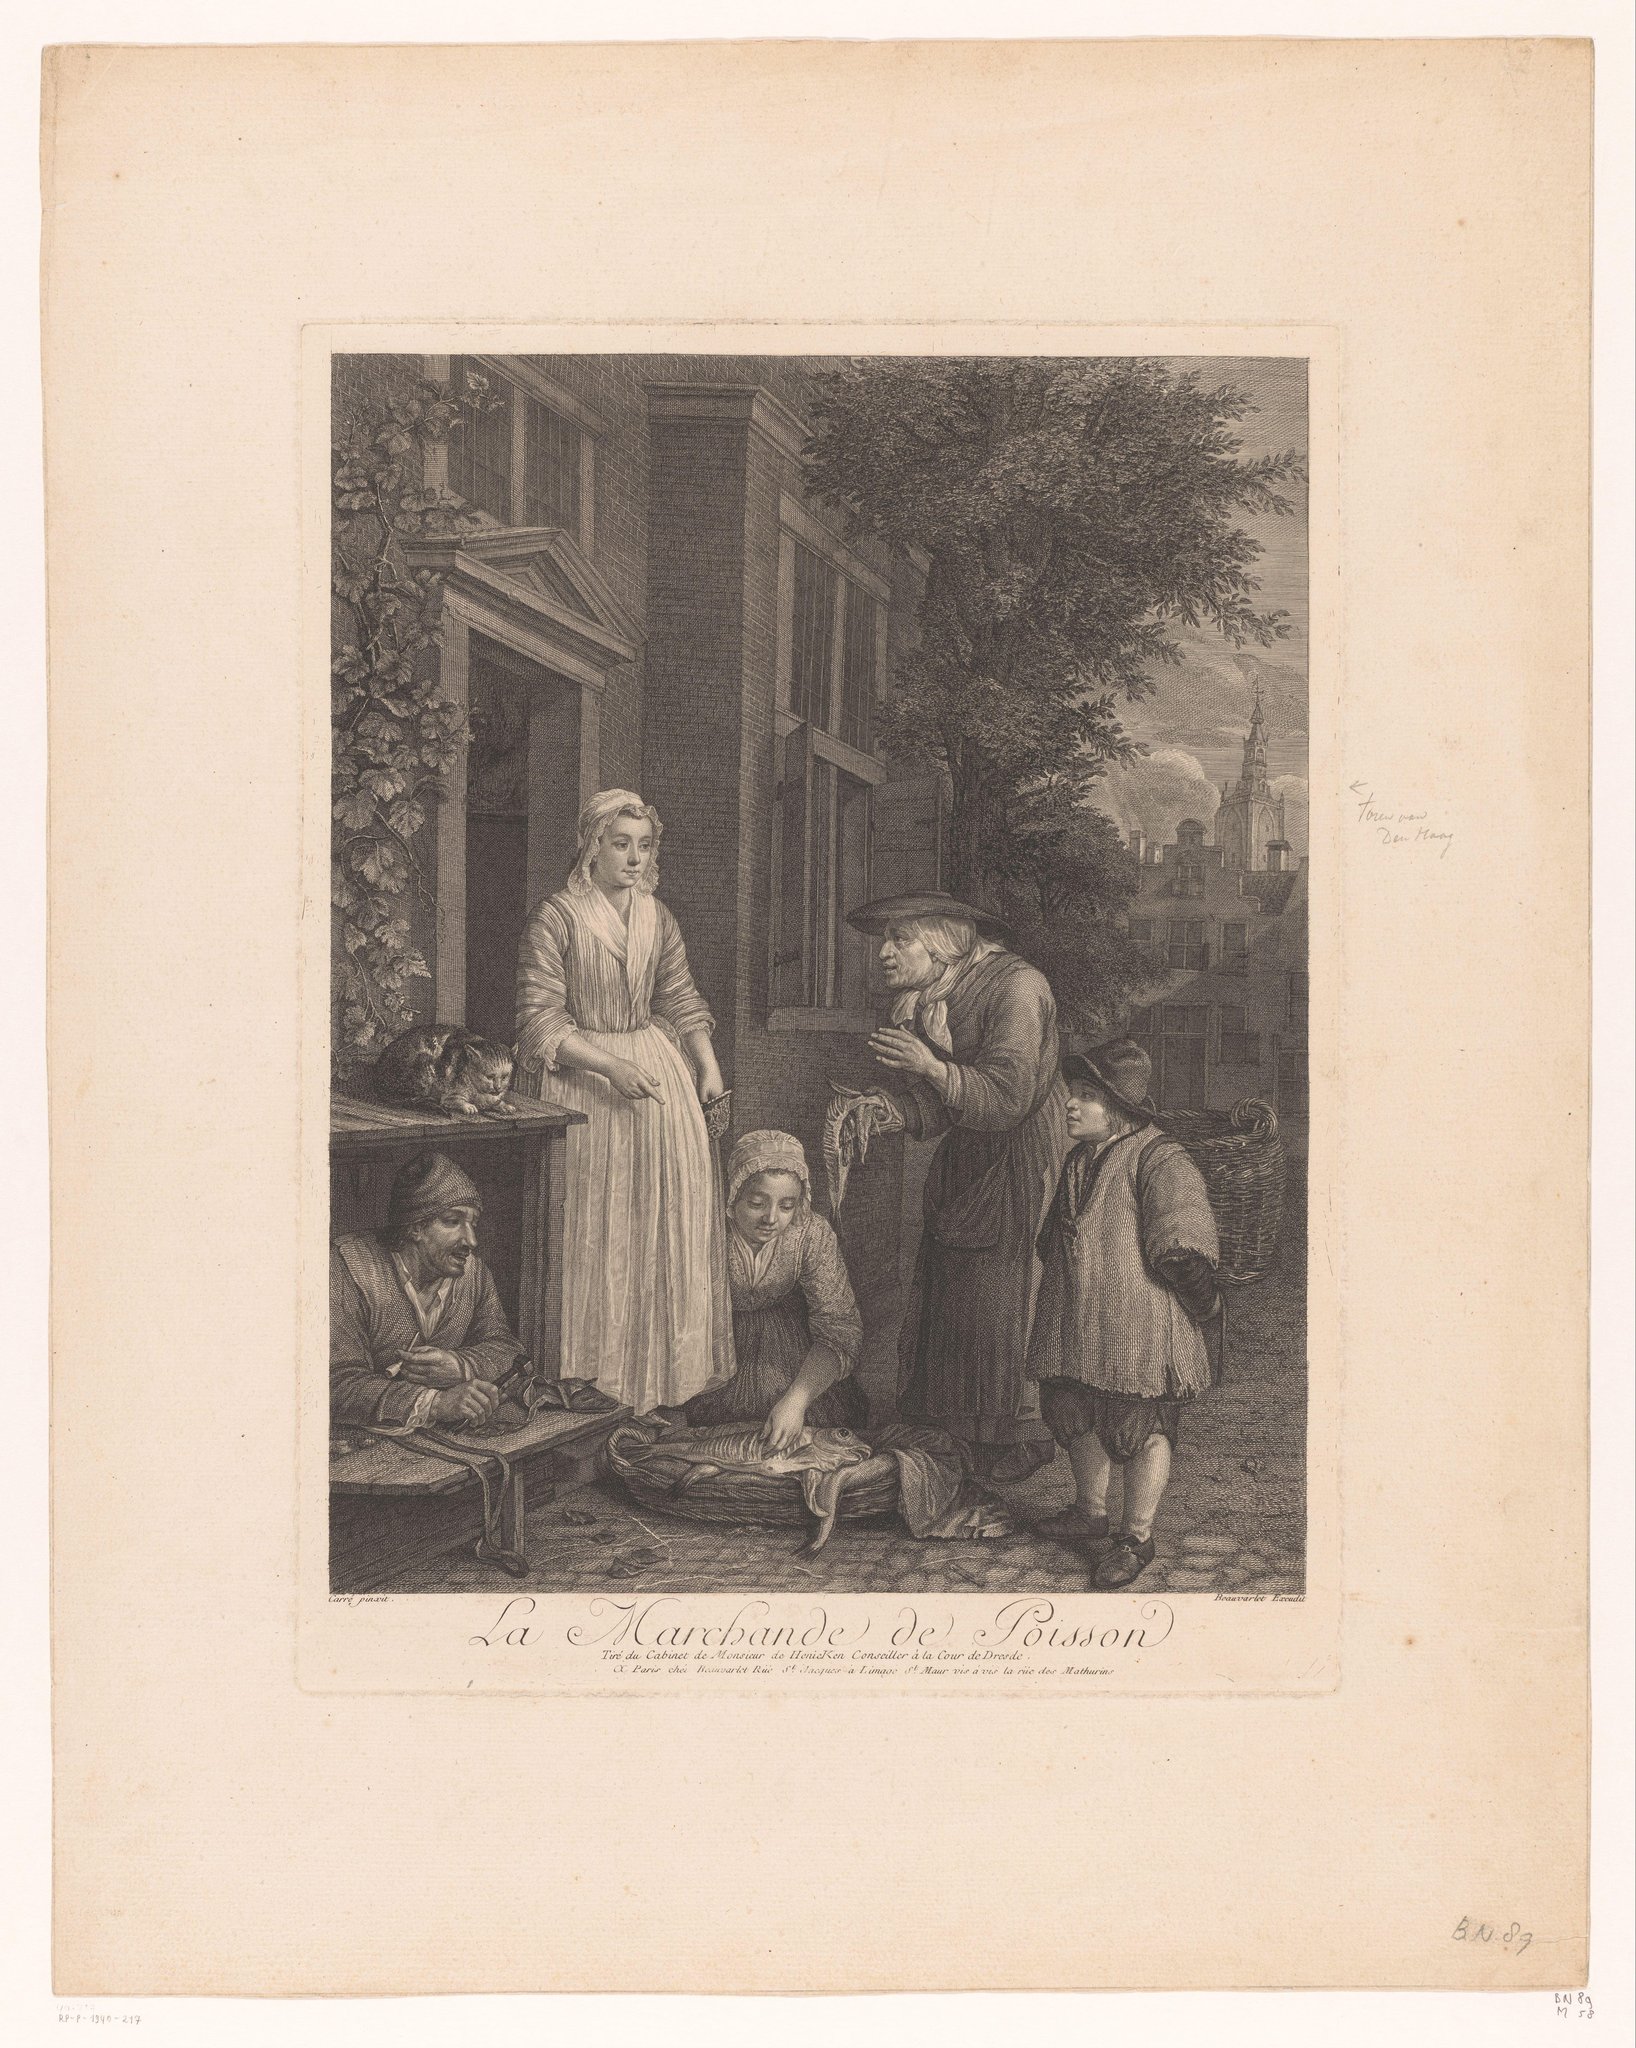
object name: print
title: La Marchande de Poisson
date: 1741-1797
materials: paper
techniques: engraving, etching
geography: paris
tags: street-trader - bb - women engaged in trade and commerce, fishes, the hague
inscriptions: collector's mark: Lugt 2228